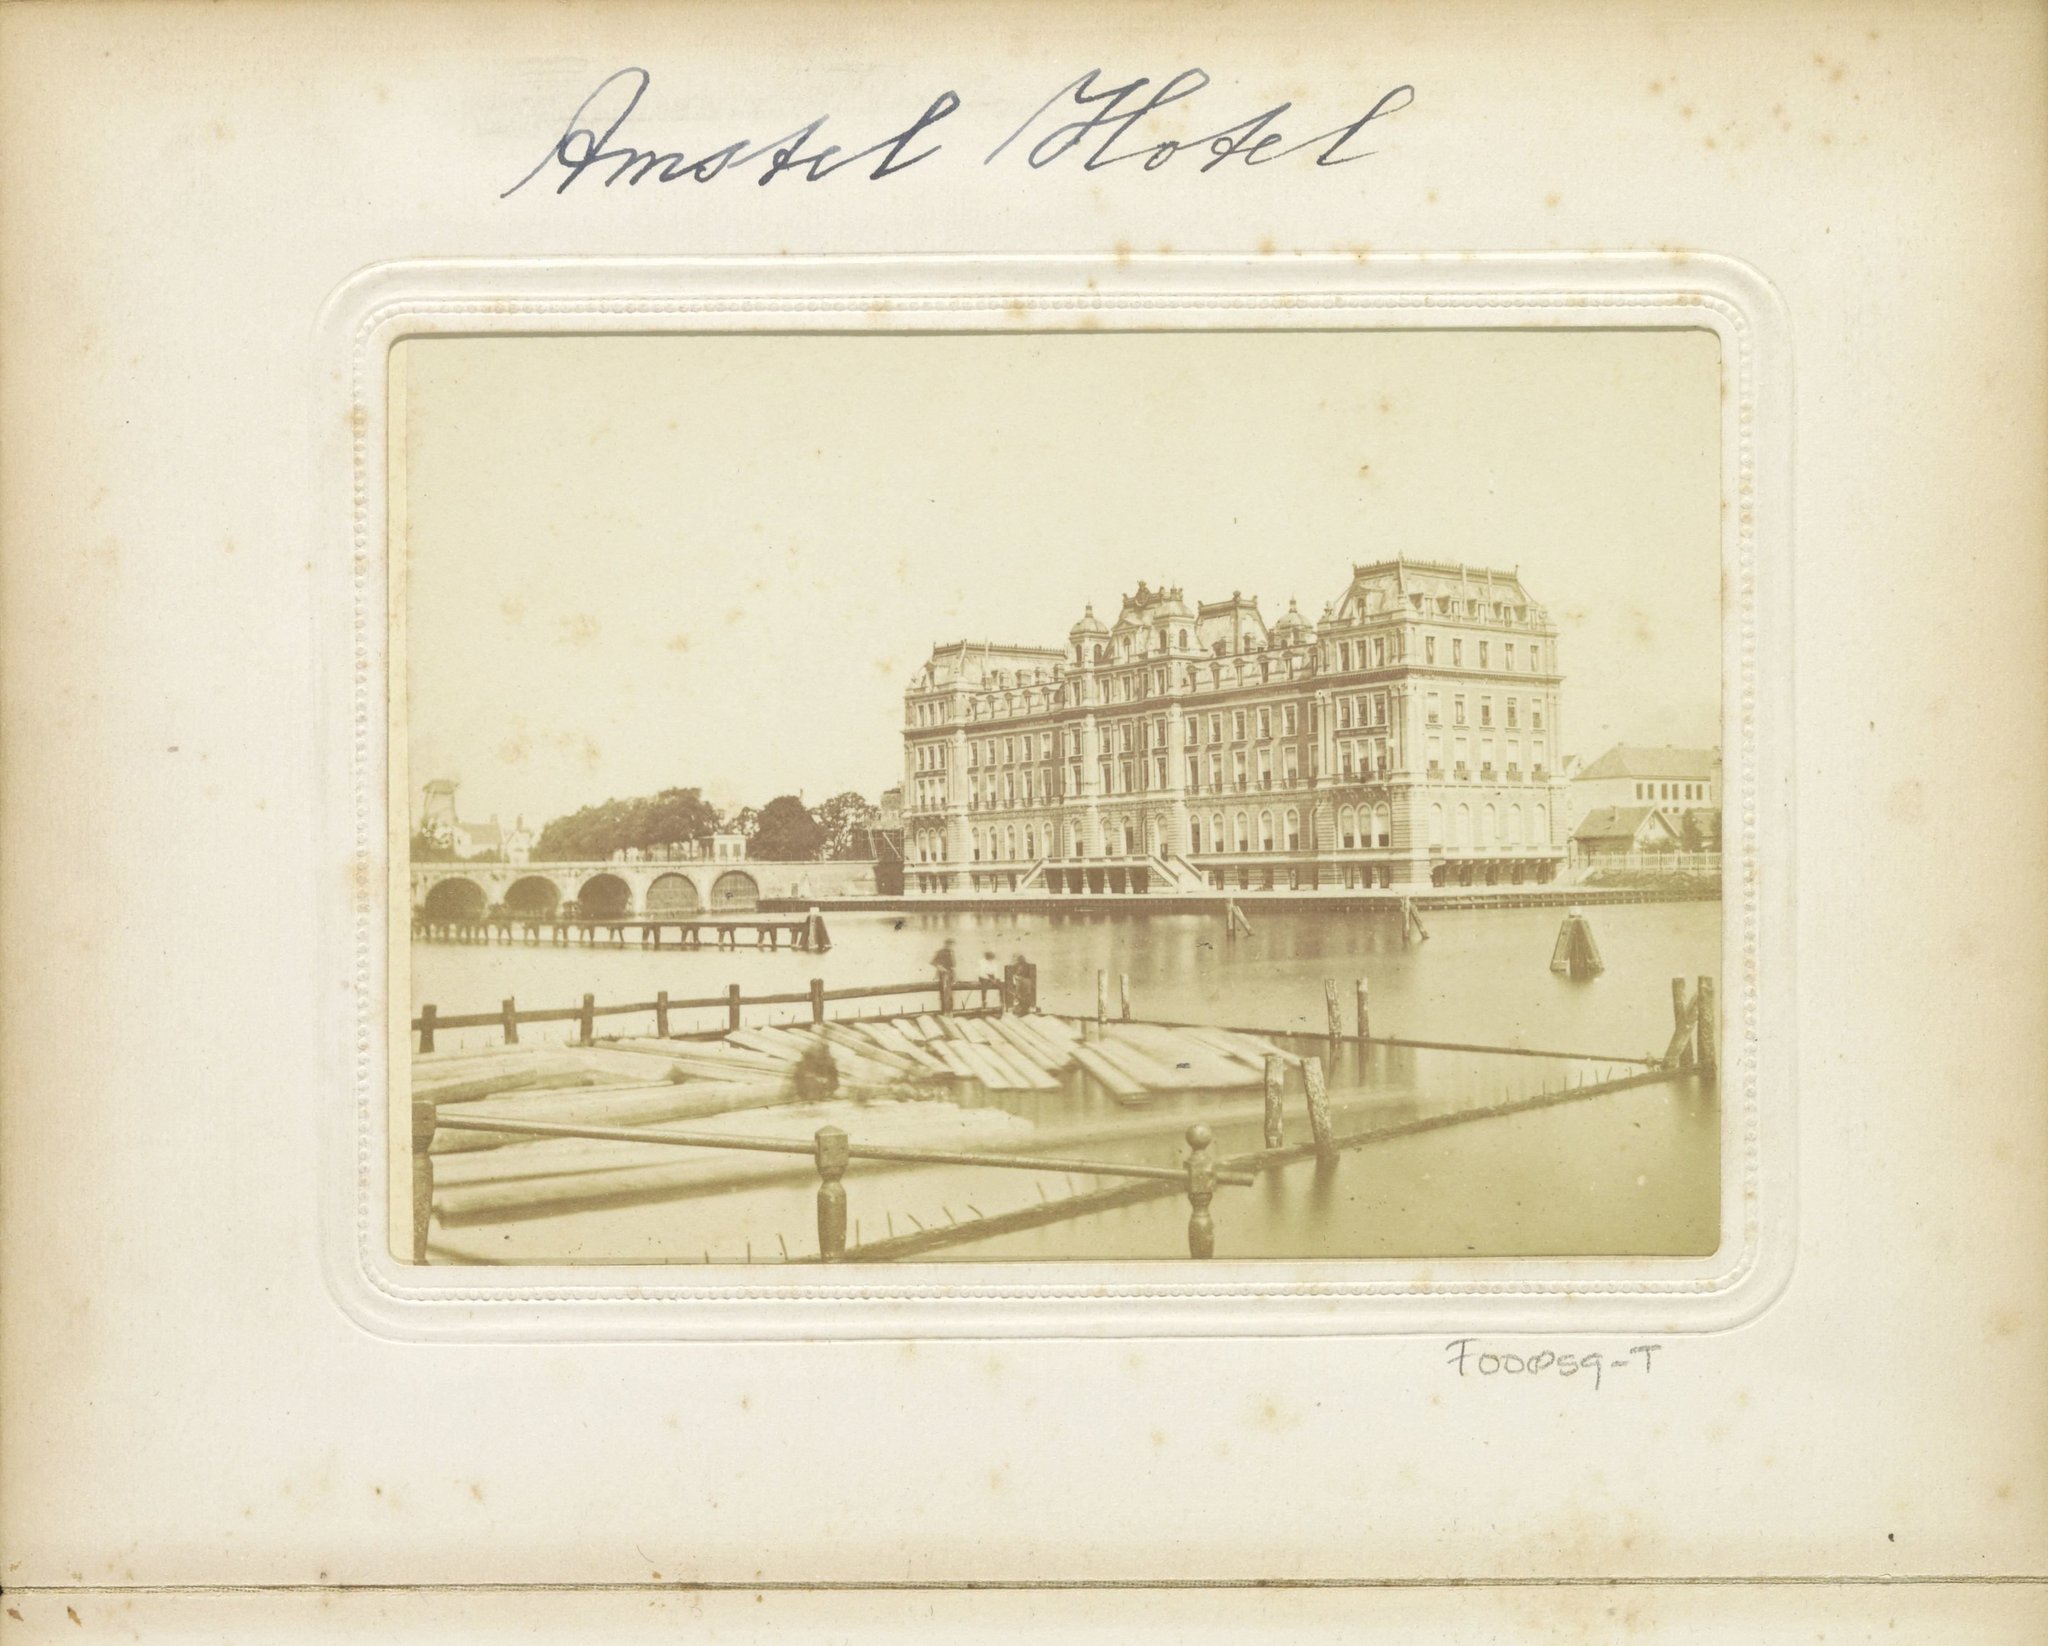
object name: photograph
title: Gezicht op het Amstel Hotel met op de voorgrond houttransport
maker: Anonymous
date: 1867-1875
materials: cardboard, paper, photographic support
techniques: albumen print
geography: amsterdam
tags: timber floating down the river, hotel, hostelry, inn, prospect of city, town panorama, silhouette of city, amsterdam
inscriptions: inscription: ‘Amstelhotel’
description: Onderdeel van Fotoalbum met opnames van straten, pleinen en grachten in Amsterdam.